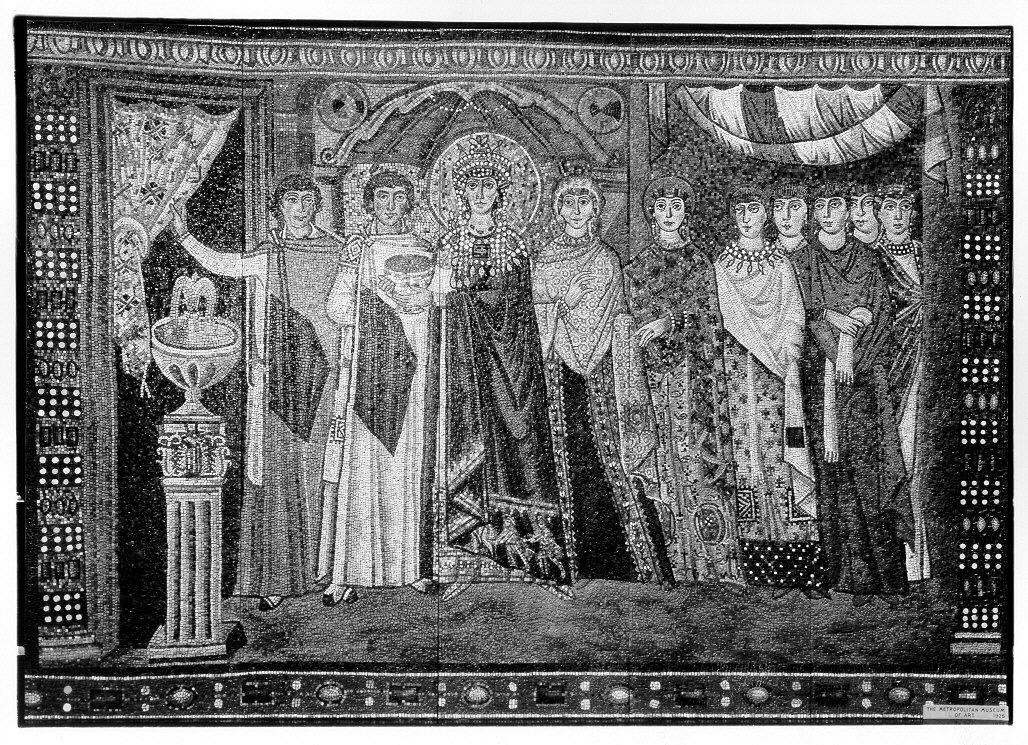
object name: mosaic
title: Empress Theodora and Members of Her Court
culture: byzantine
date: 1901-1933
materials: glass, stone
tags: men